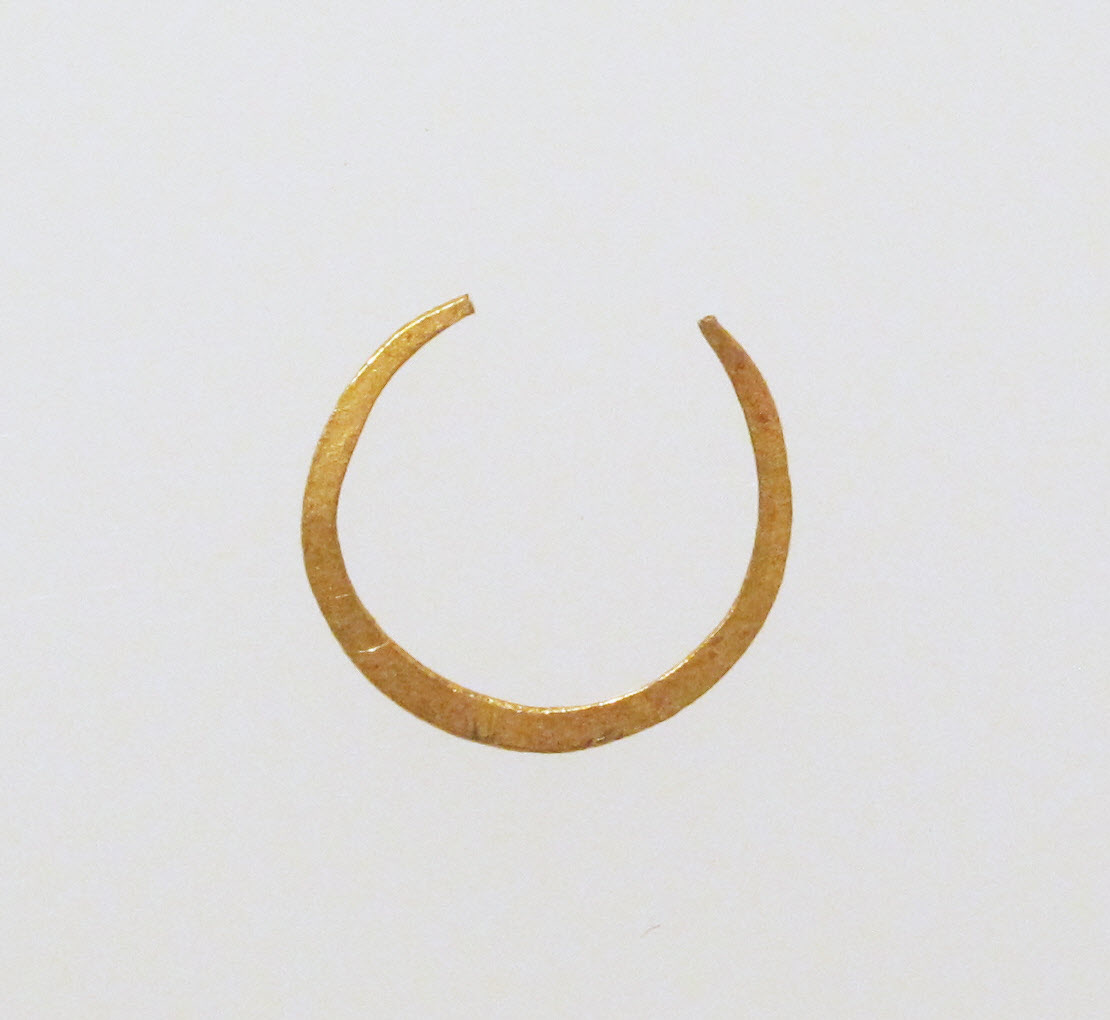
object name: earring loop type, hammered flat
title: Earring-loop type, hammered flat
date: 7000 BCE-330 CE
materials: gold